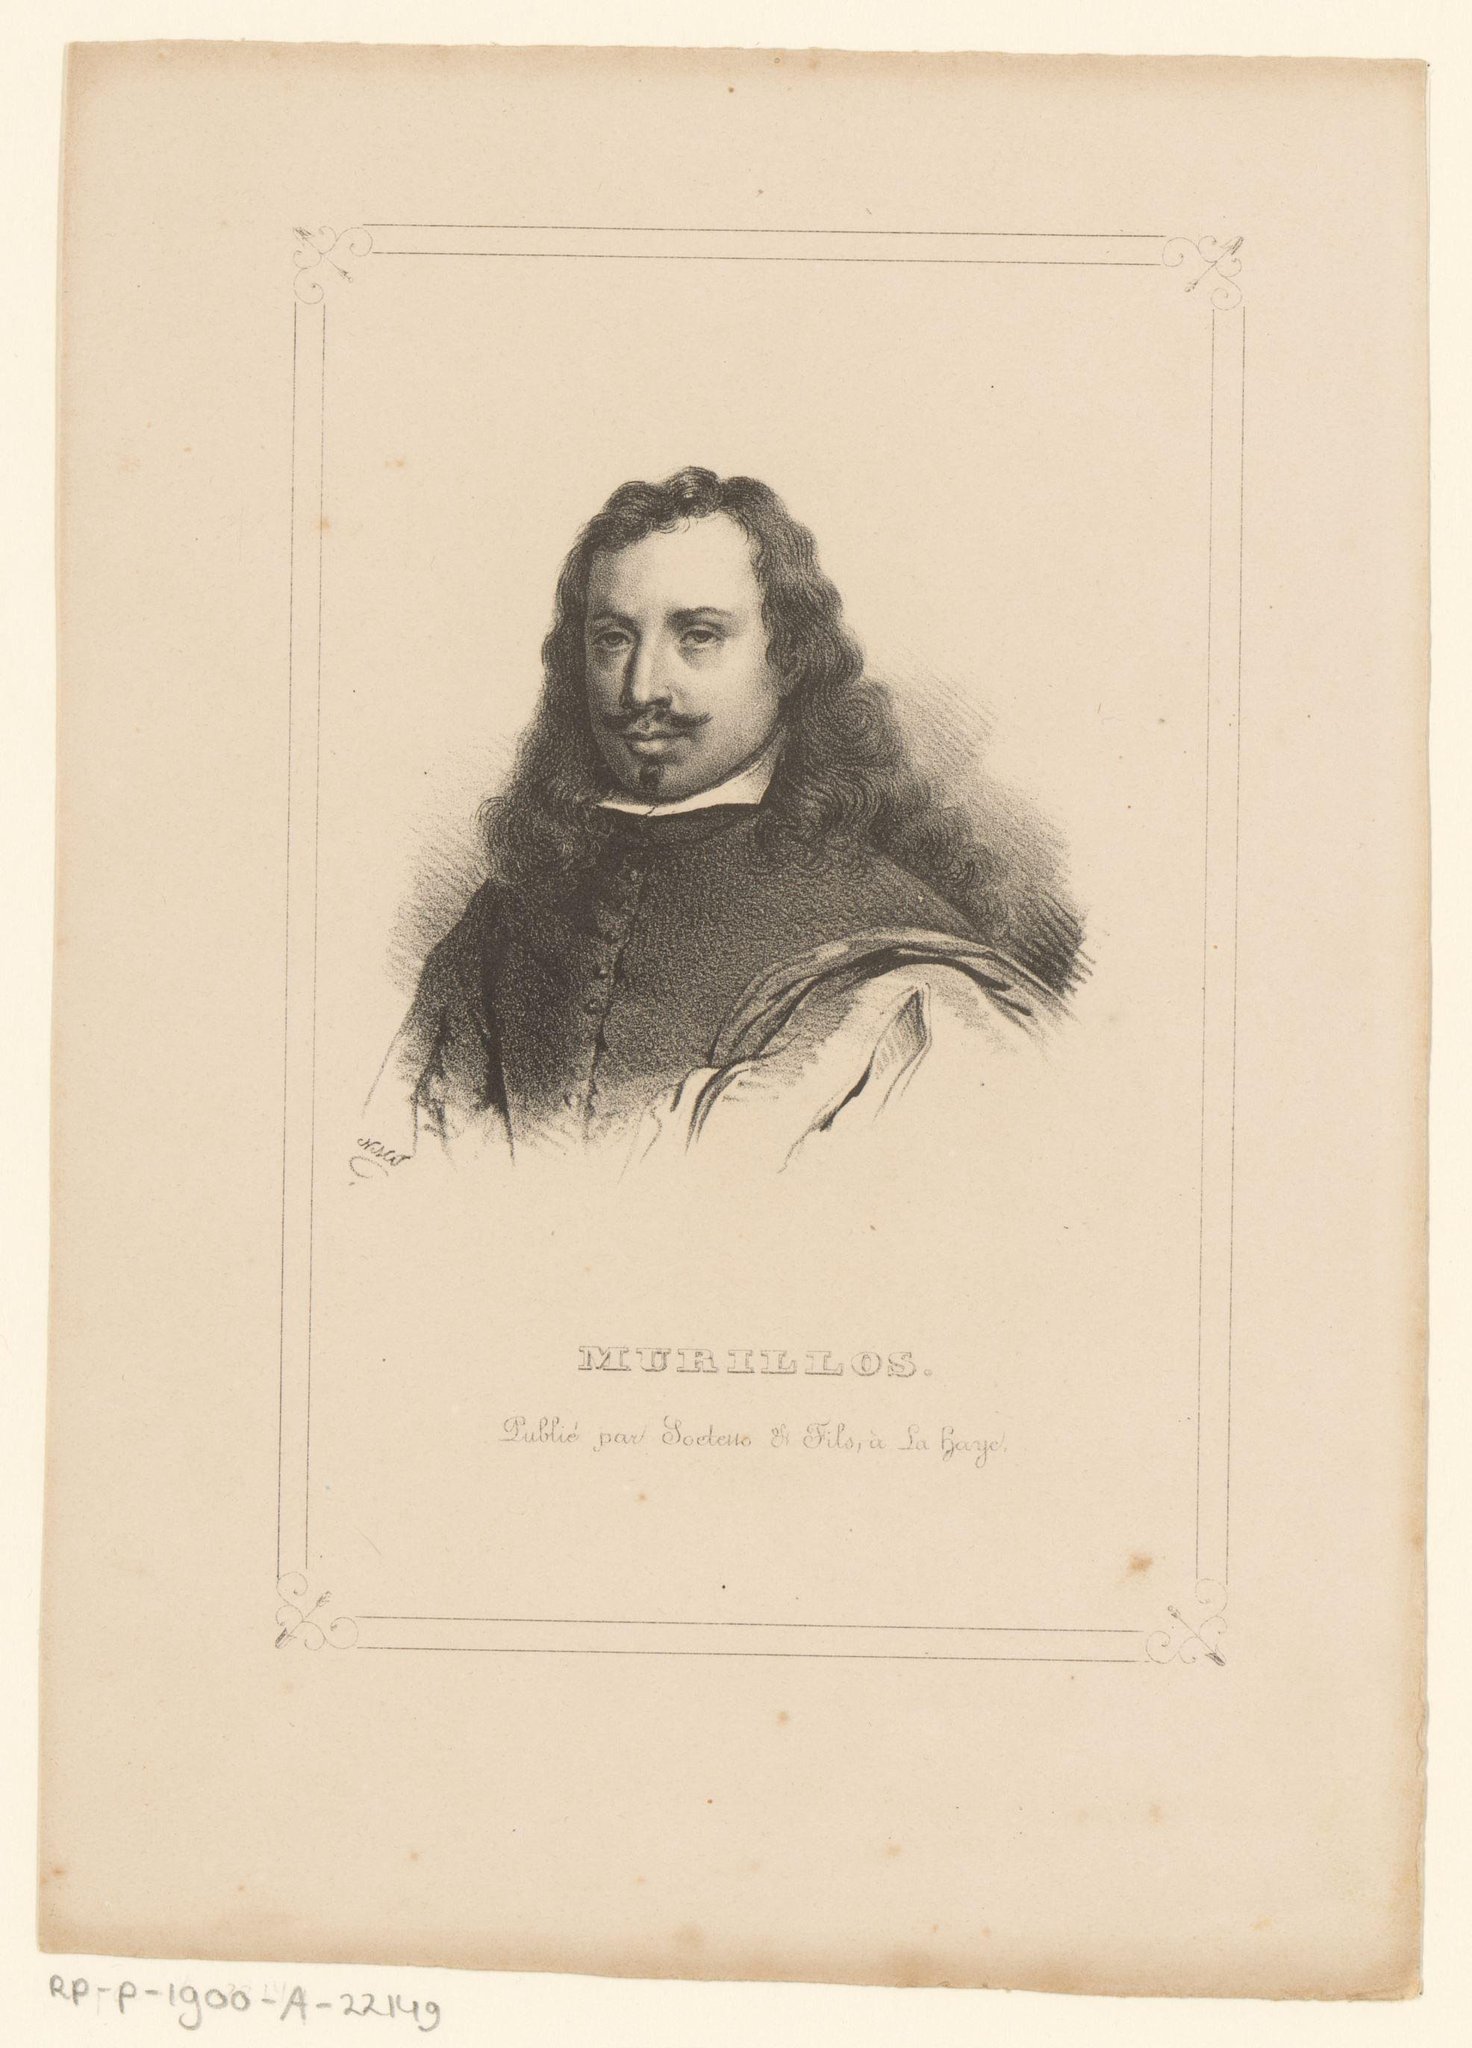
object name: print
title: Portret van Bartolomé Murillo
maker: nicolaas martinus schild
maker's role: draughtsman, print maker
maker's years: 1822-1840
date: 1837-1840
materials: paper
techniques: lithograph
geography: the hague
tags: sevilla, painter, draughtsman, bartolomé esteban murillo, portrait, self-portrait of painter, historical persons (+ (full) bust portrait)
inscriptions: collector's mark: Lugt 2228